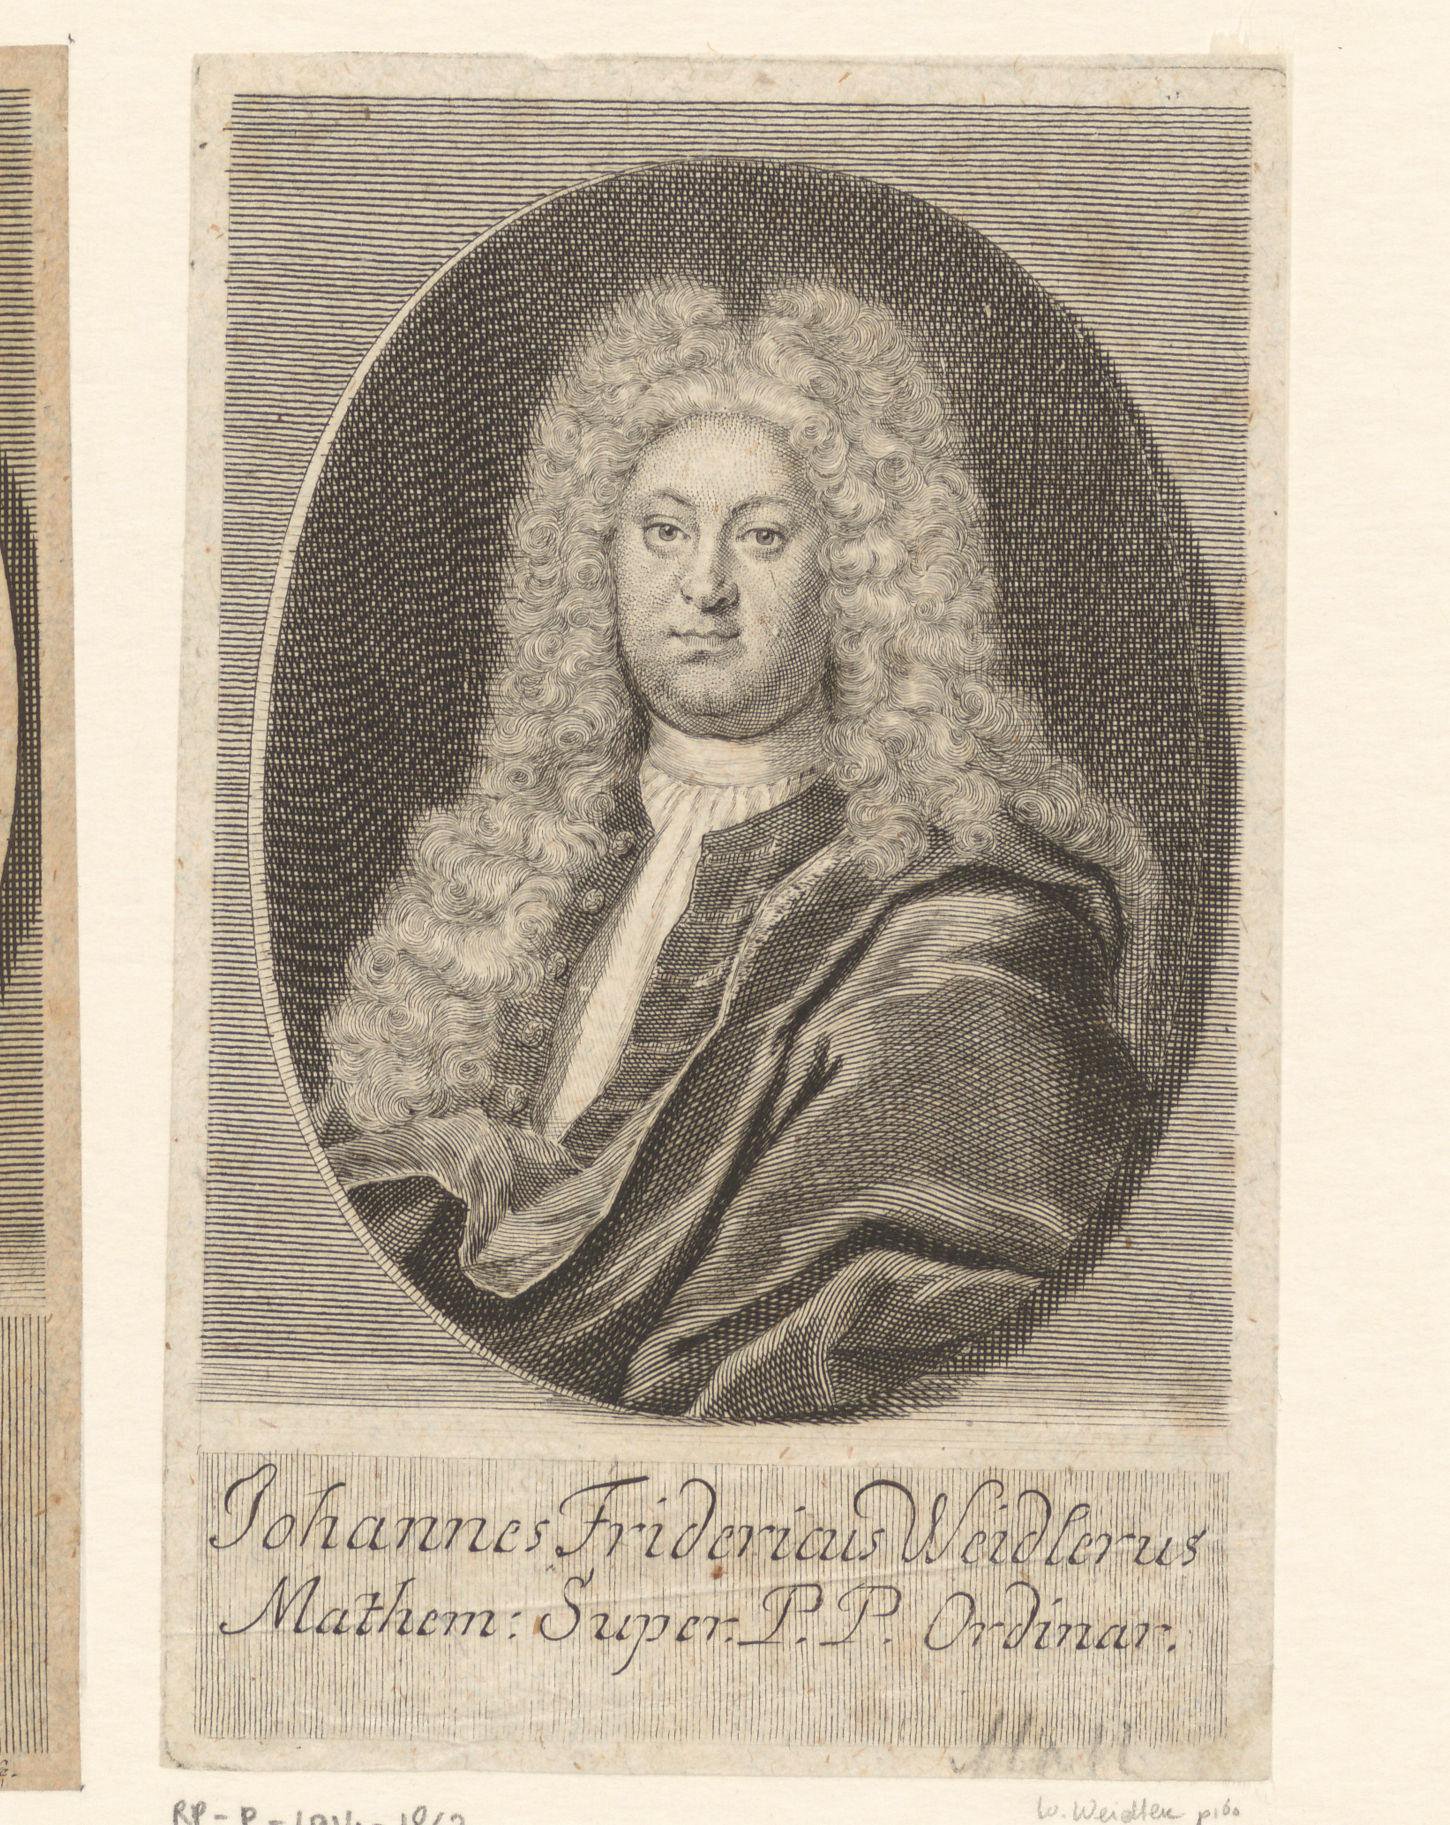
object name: print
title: Johannes Fridericus Weidlerus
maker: martin bernigeroth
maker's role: print maker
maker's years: 1670-1733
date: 1680-1733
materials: paper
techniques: engraving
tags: historical persons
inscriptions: collector's mark: Lugt 2228